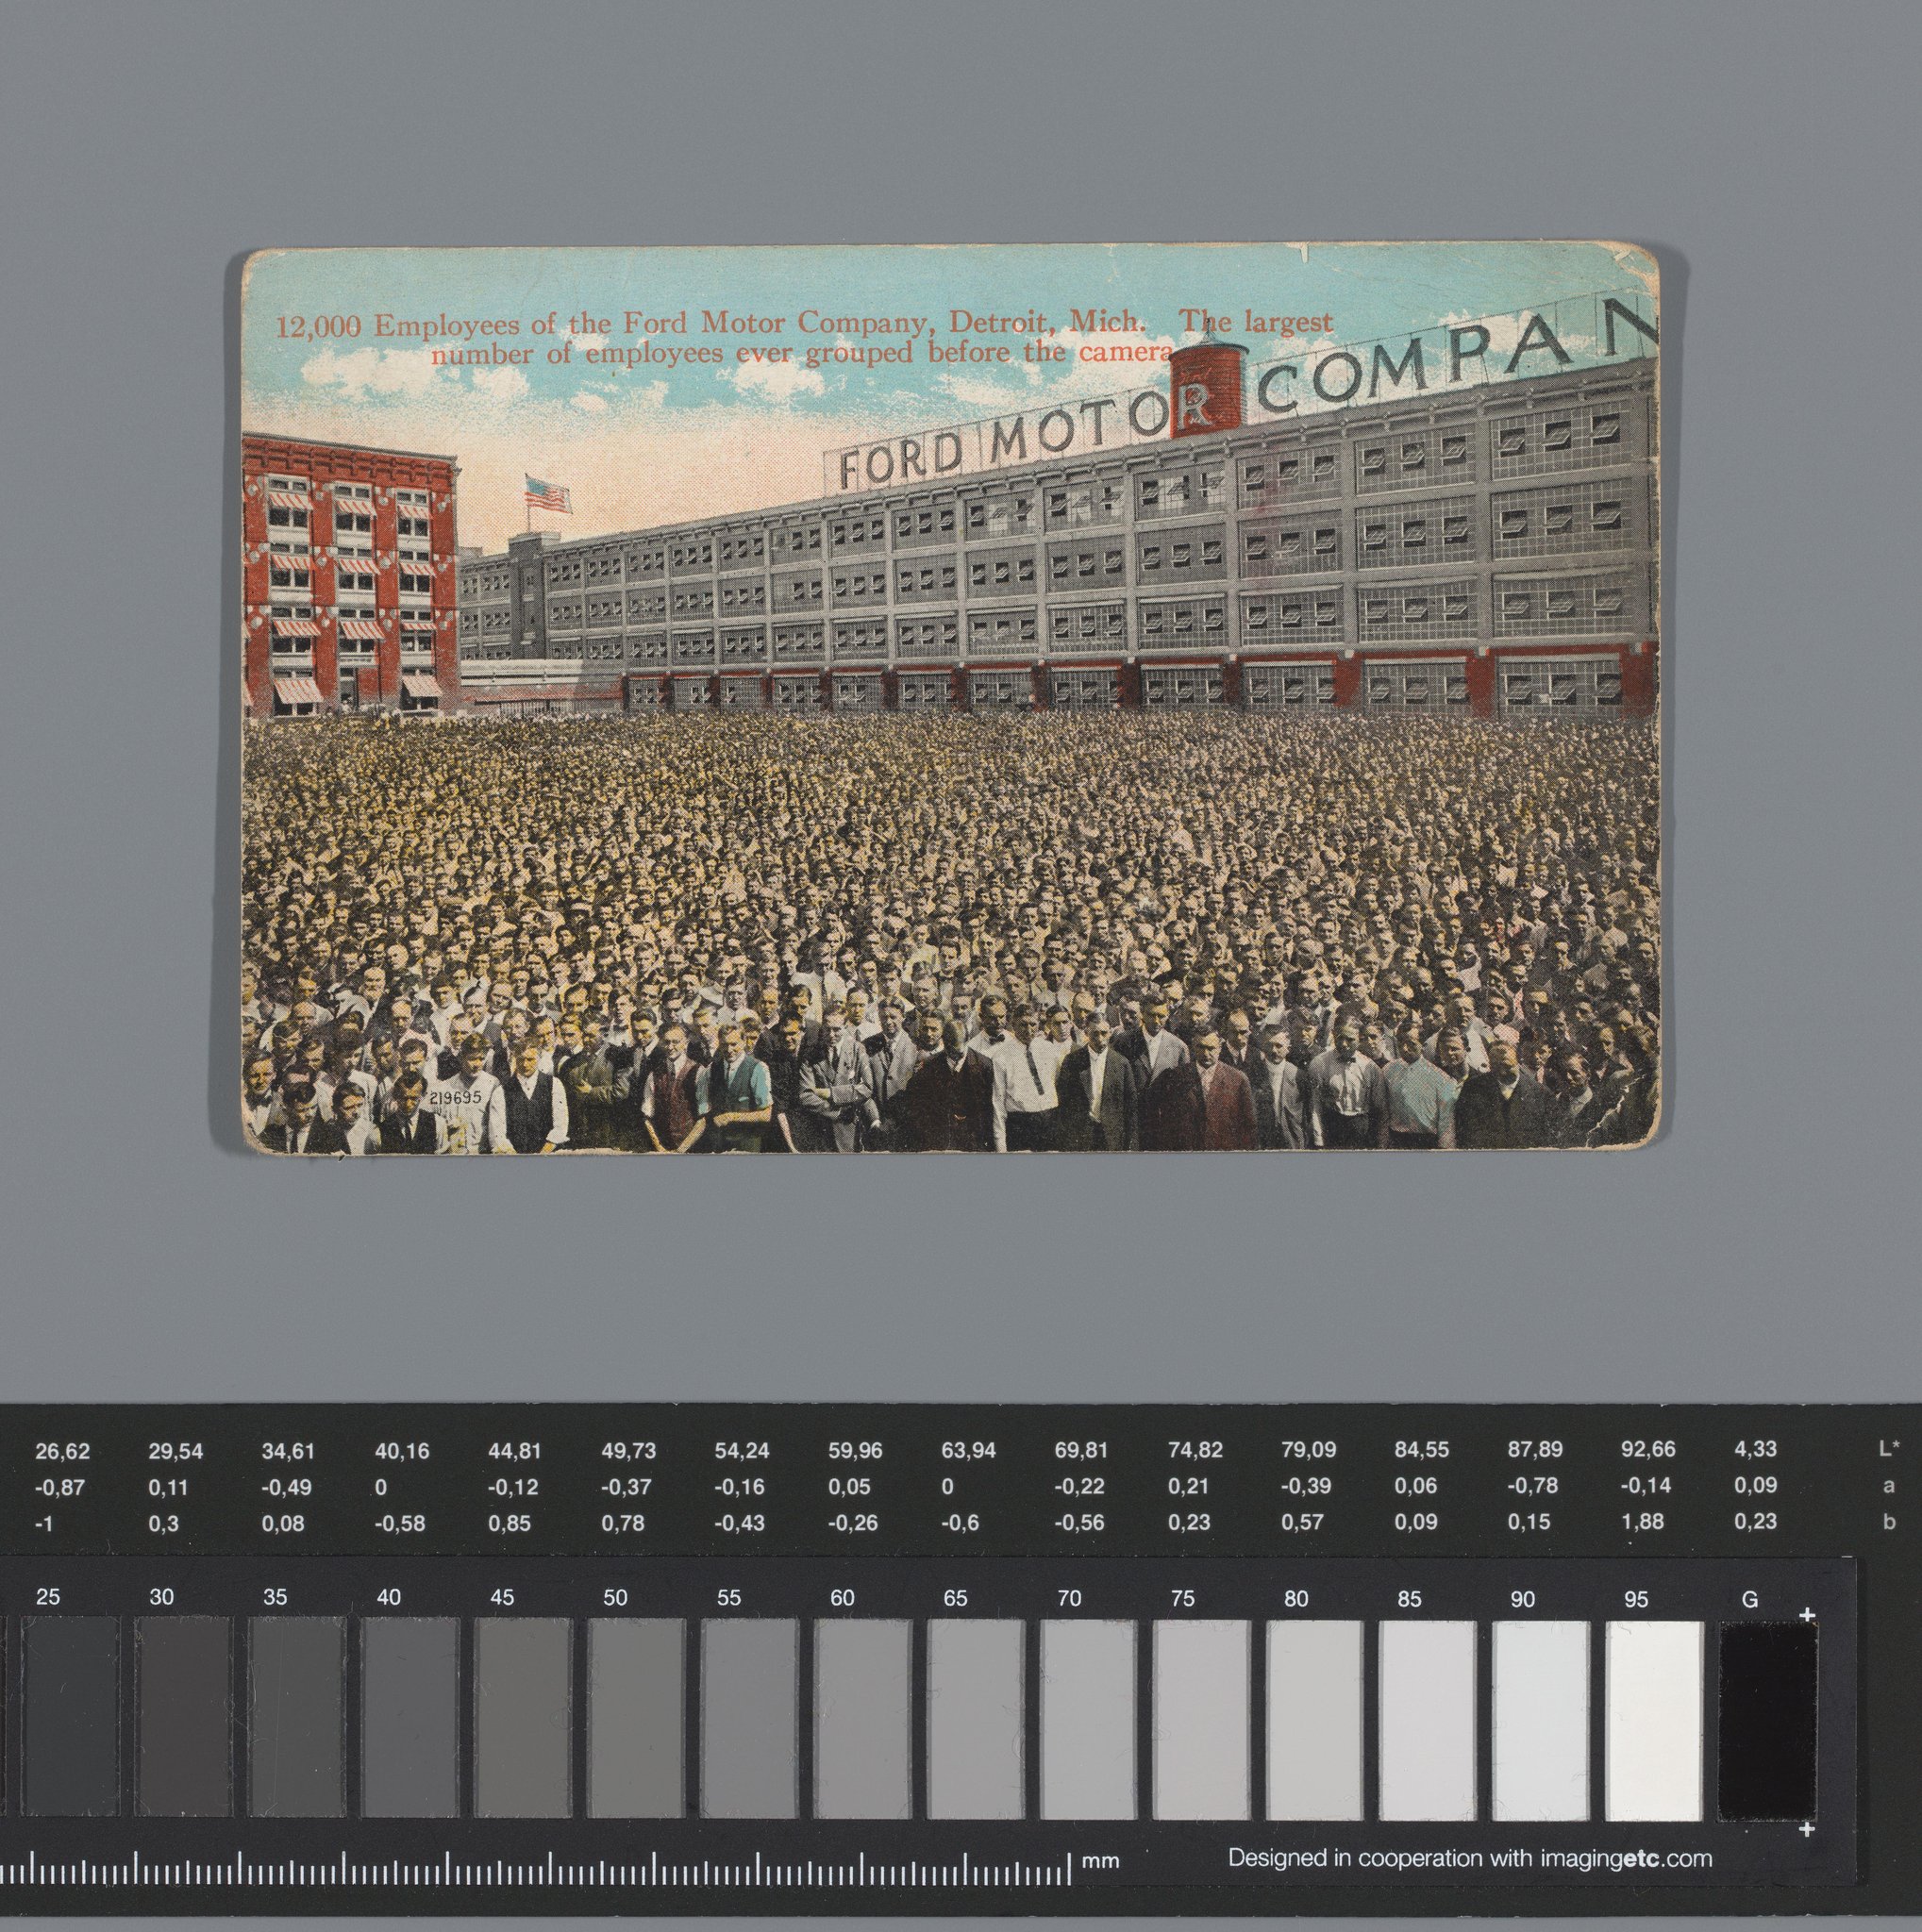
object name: ansichtkaart, prentbriefkaart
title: Alle werknemers van de Ford Motor Company staand voor de fabriek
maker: Anonymous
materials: paper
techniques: lithograph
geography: united states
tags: ford motor company, detroit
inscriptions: inscription: ‘12,000 Employees of the Ford Moter Company, Detroit, Mich. The largest / number of employees ever grouped before the camera’